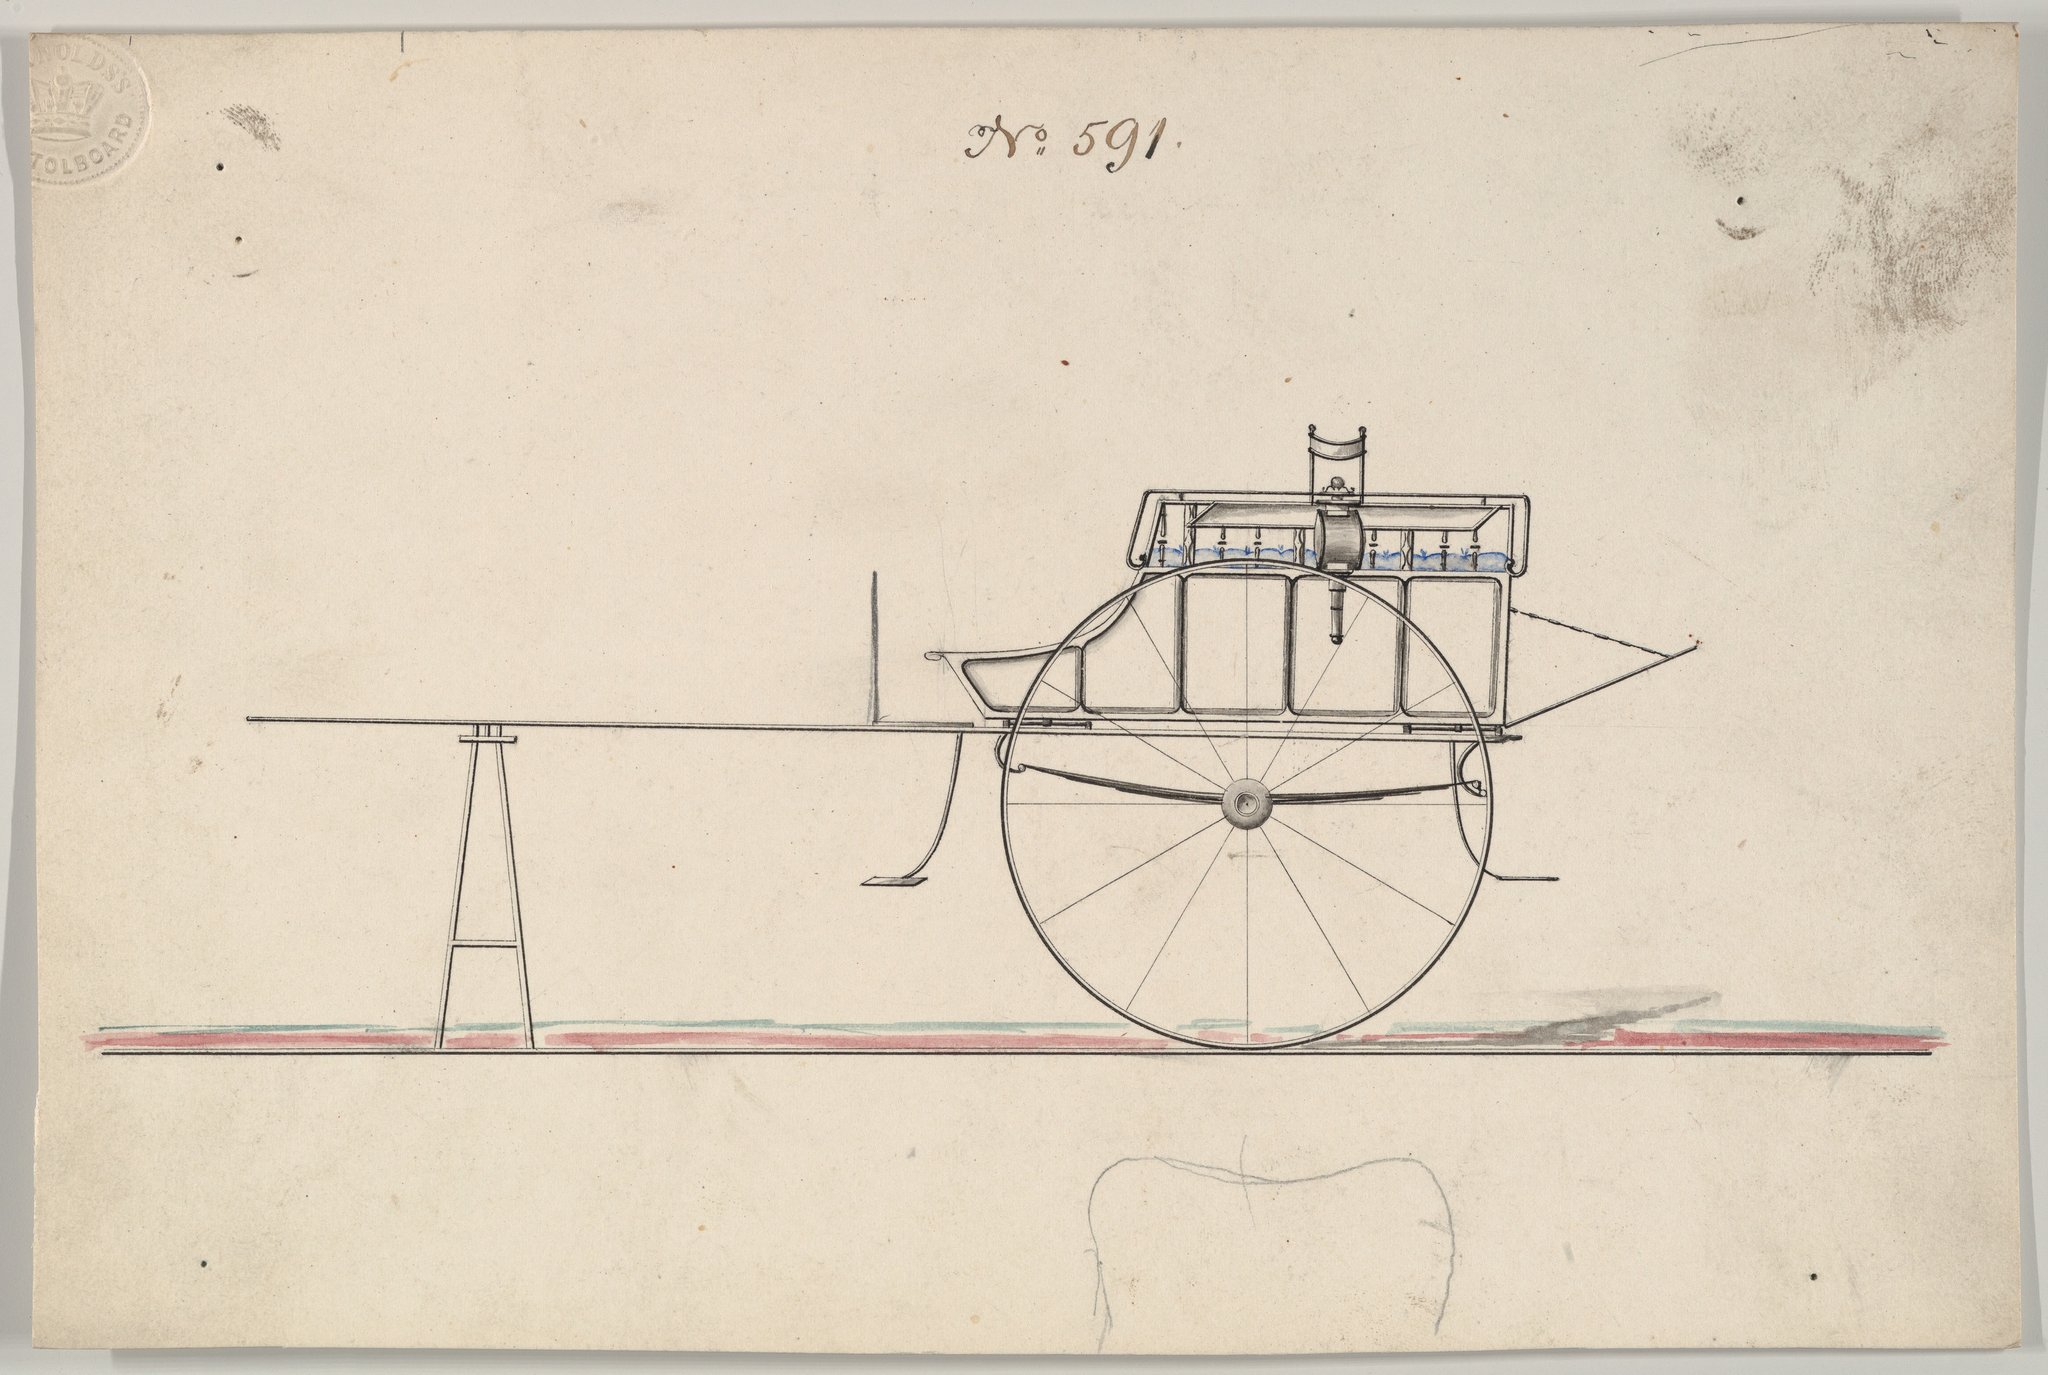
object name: drawing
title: White Chapel Cart #591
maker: brewster & co.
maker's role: manufacturer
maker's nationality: american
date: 1865-1870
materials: graphite, ink, watercolor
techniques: pen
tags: carriages